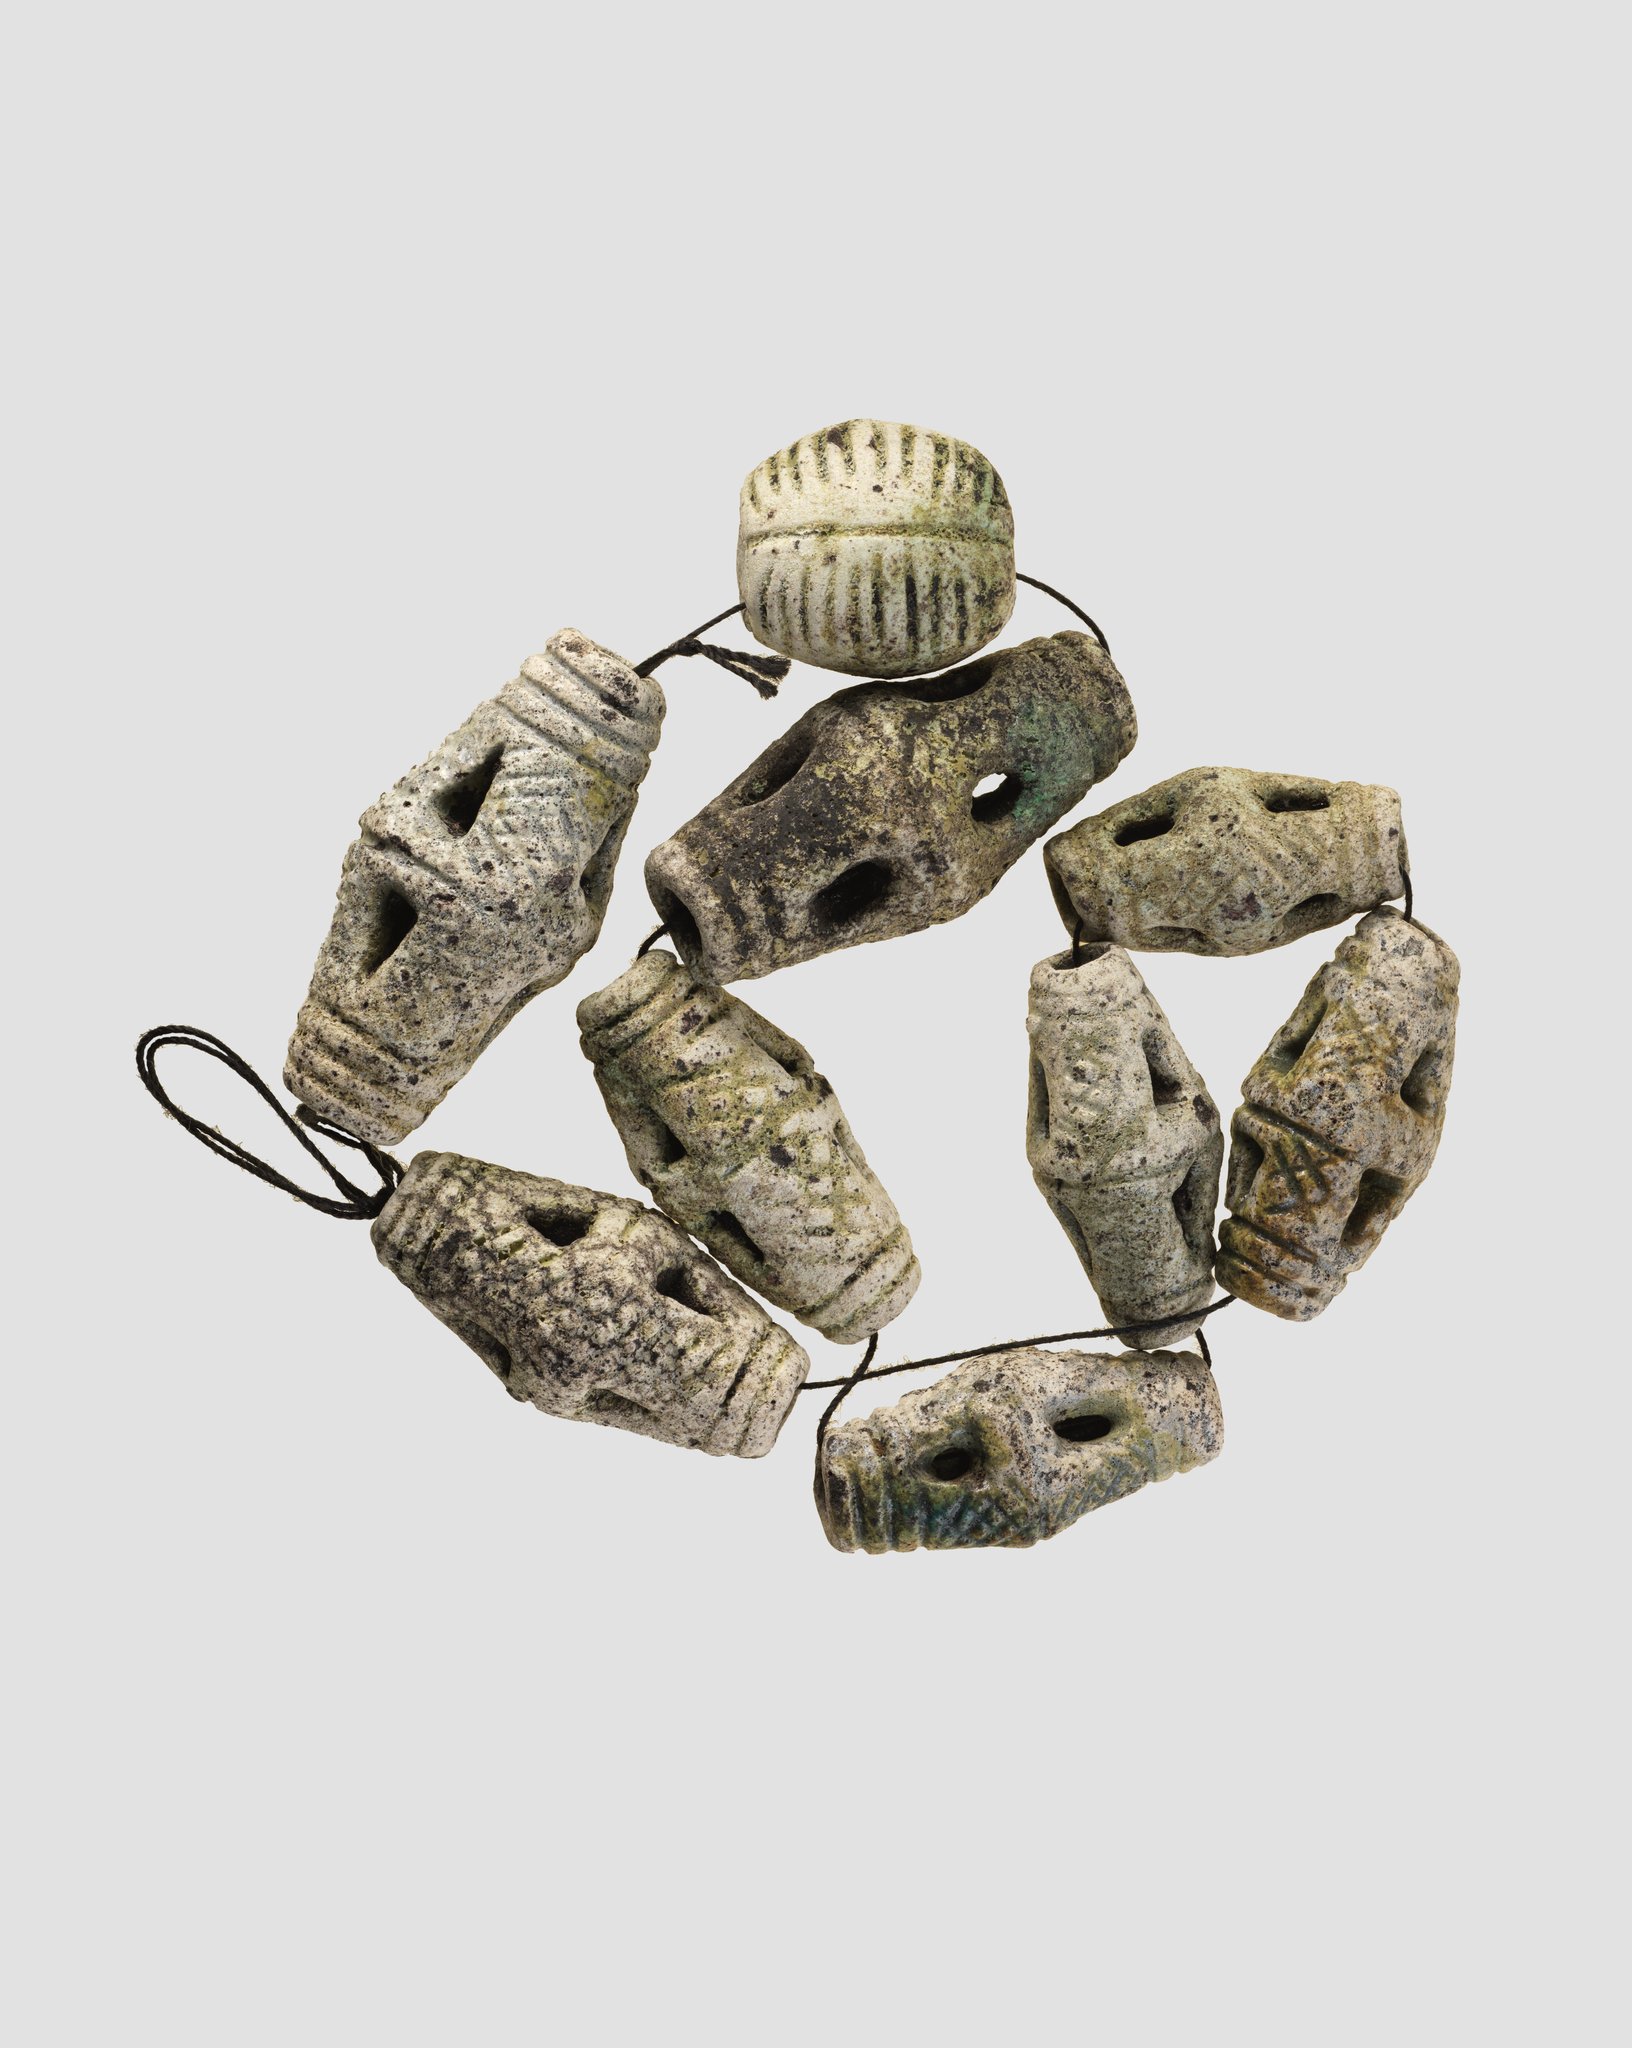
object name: bead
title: Sixteen beads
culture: iranian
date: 900-801 BCE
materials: faience, glaze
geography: iran